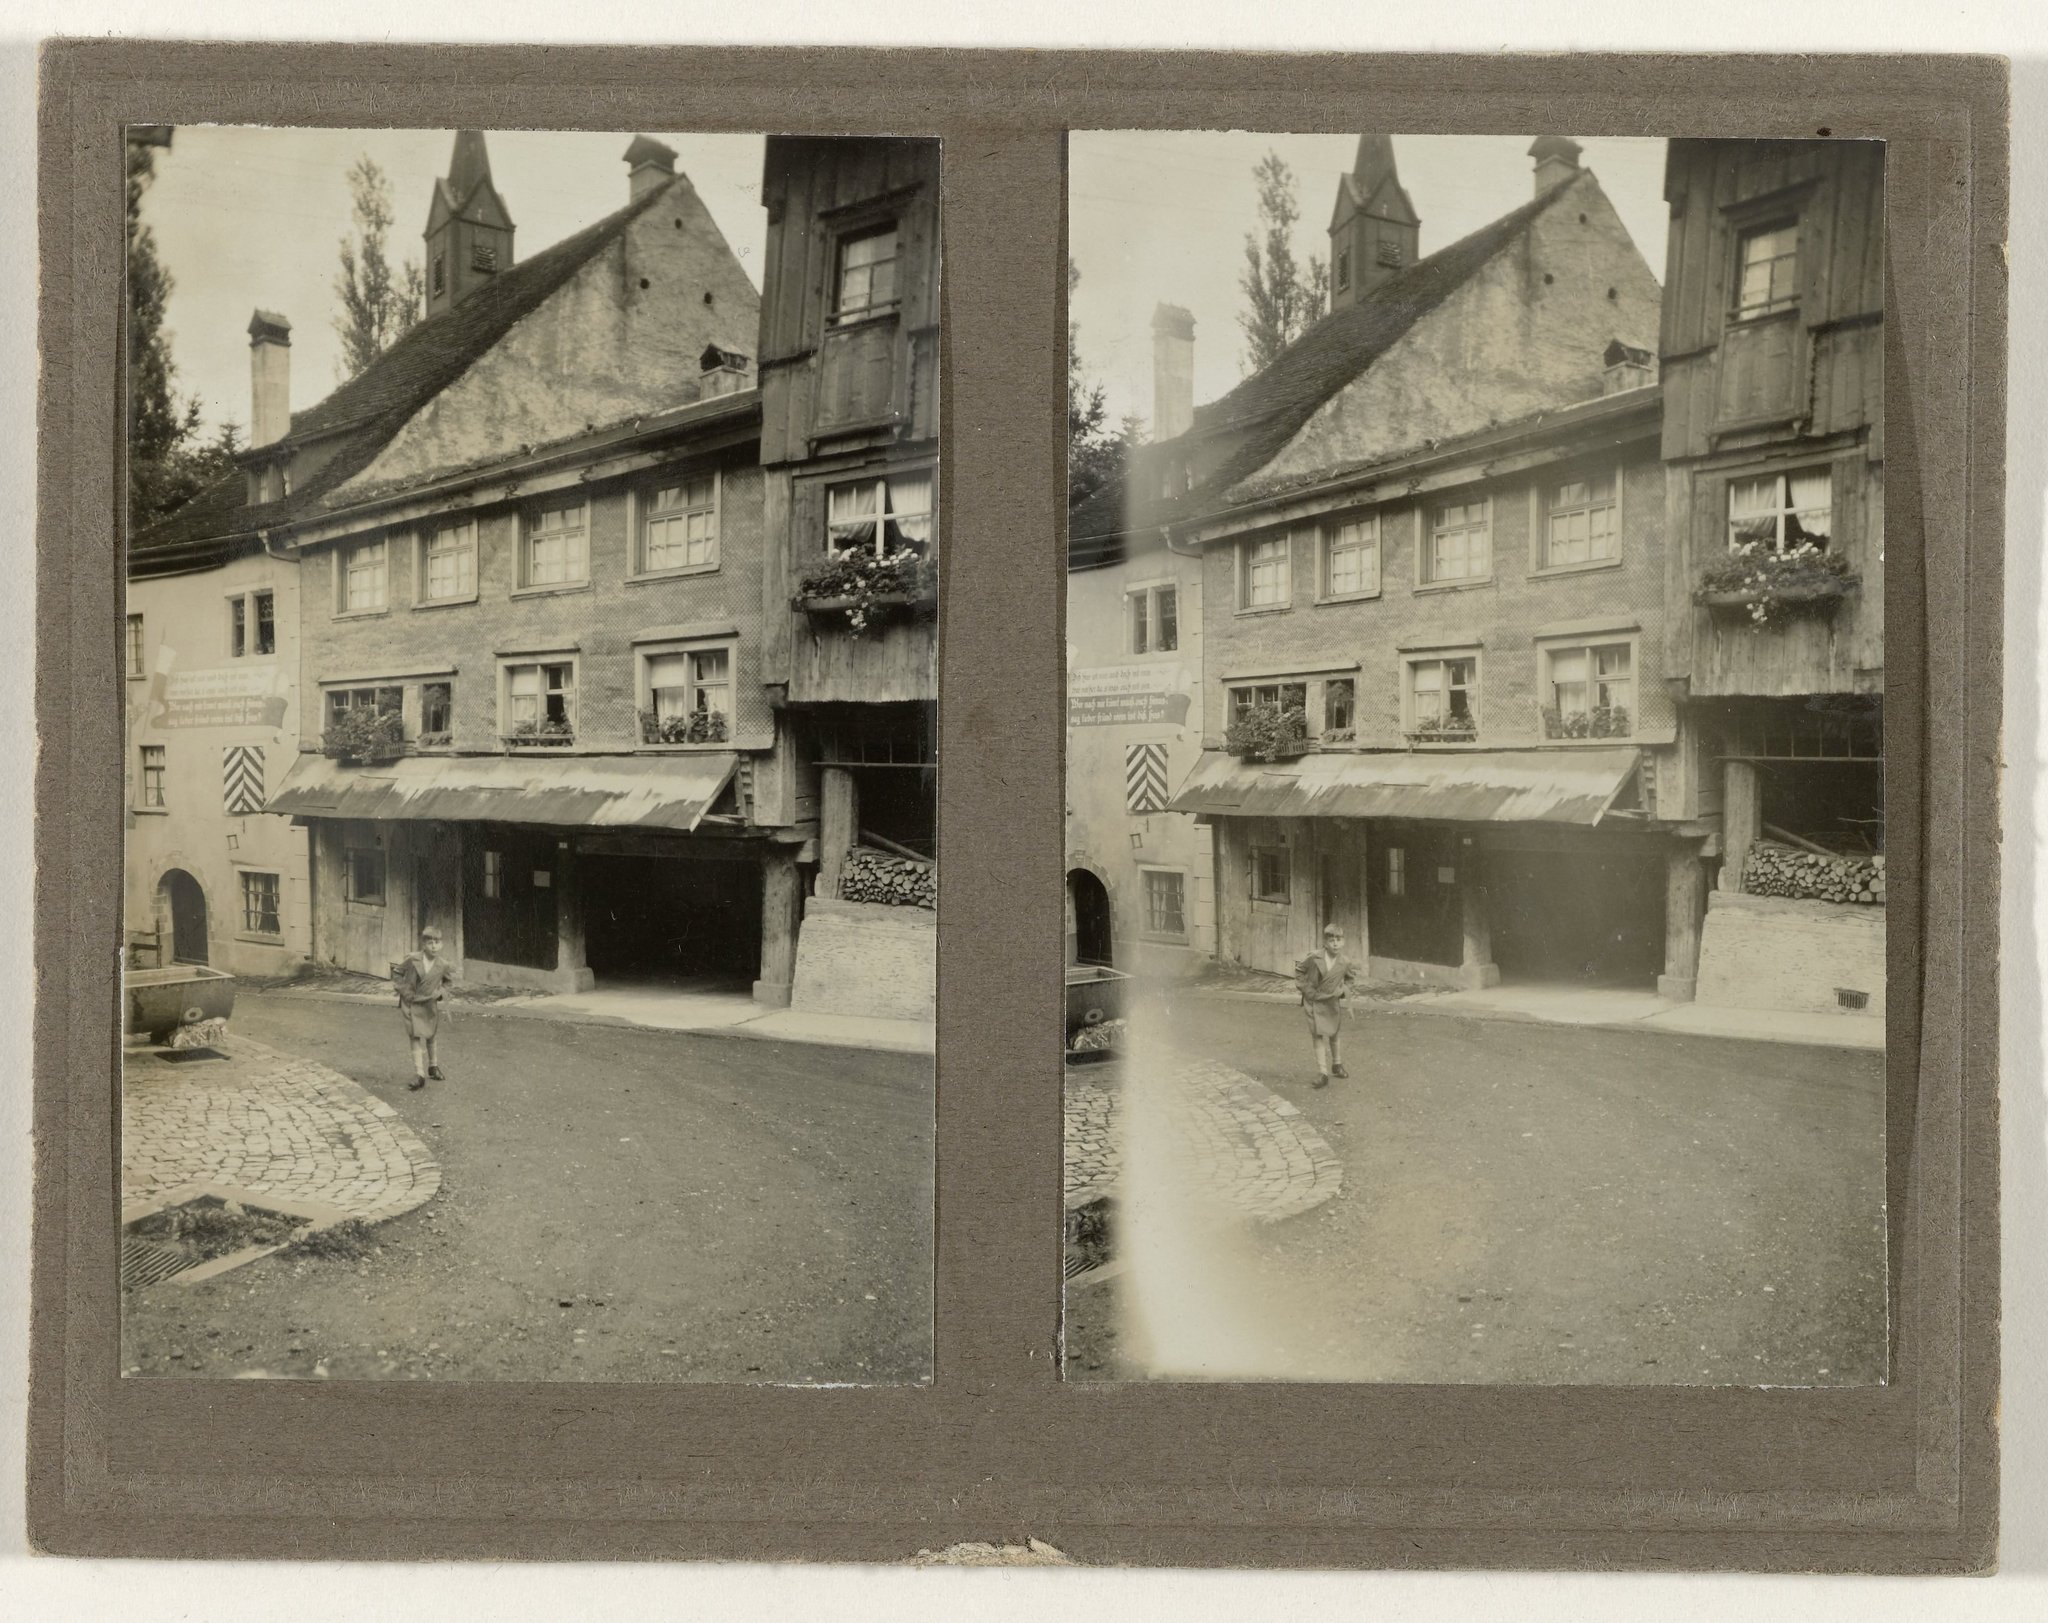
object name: stereograph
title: Straatgezicht met een lopende jongen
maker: geldolph adriaan kessler (dolph)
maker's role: fotograaf, industrieel, voetballer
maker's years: 1884-1945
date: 1895-1903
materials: paper, photographic support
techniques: collodion silver print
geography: netherlands